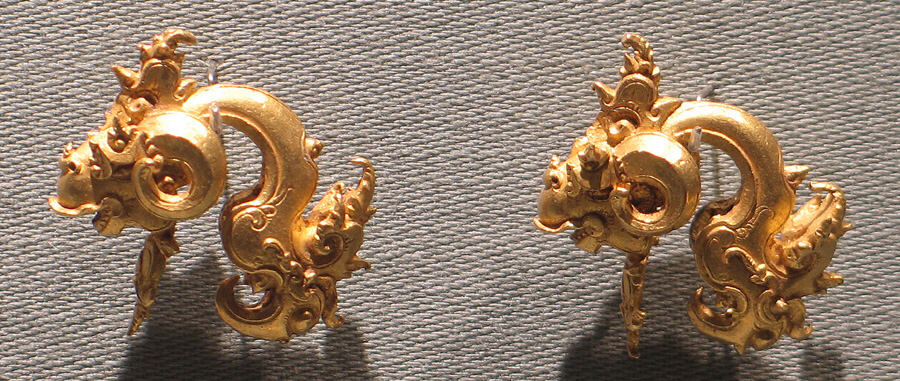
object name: ear ornament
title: Pair of Ear Ornaments with Ram's Head Motif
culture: indonesian, javanese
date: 801-1400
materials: gold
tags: rams